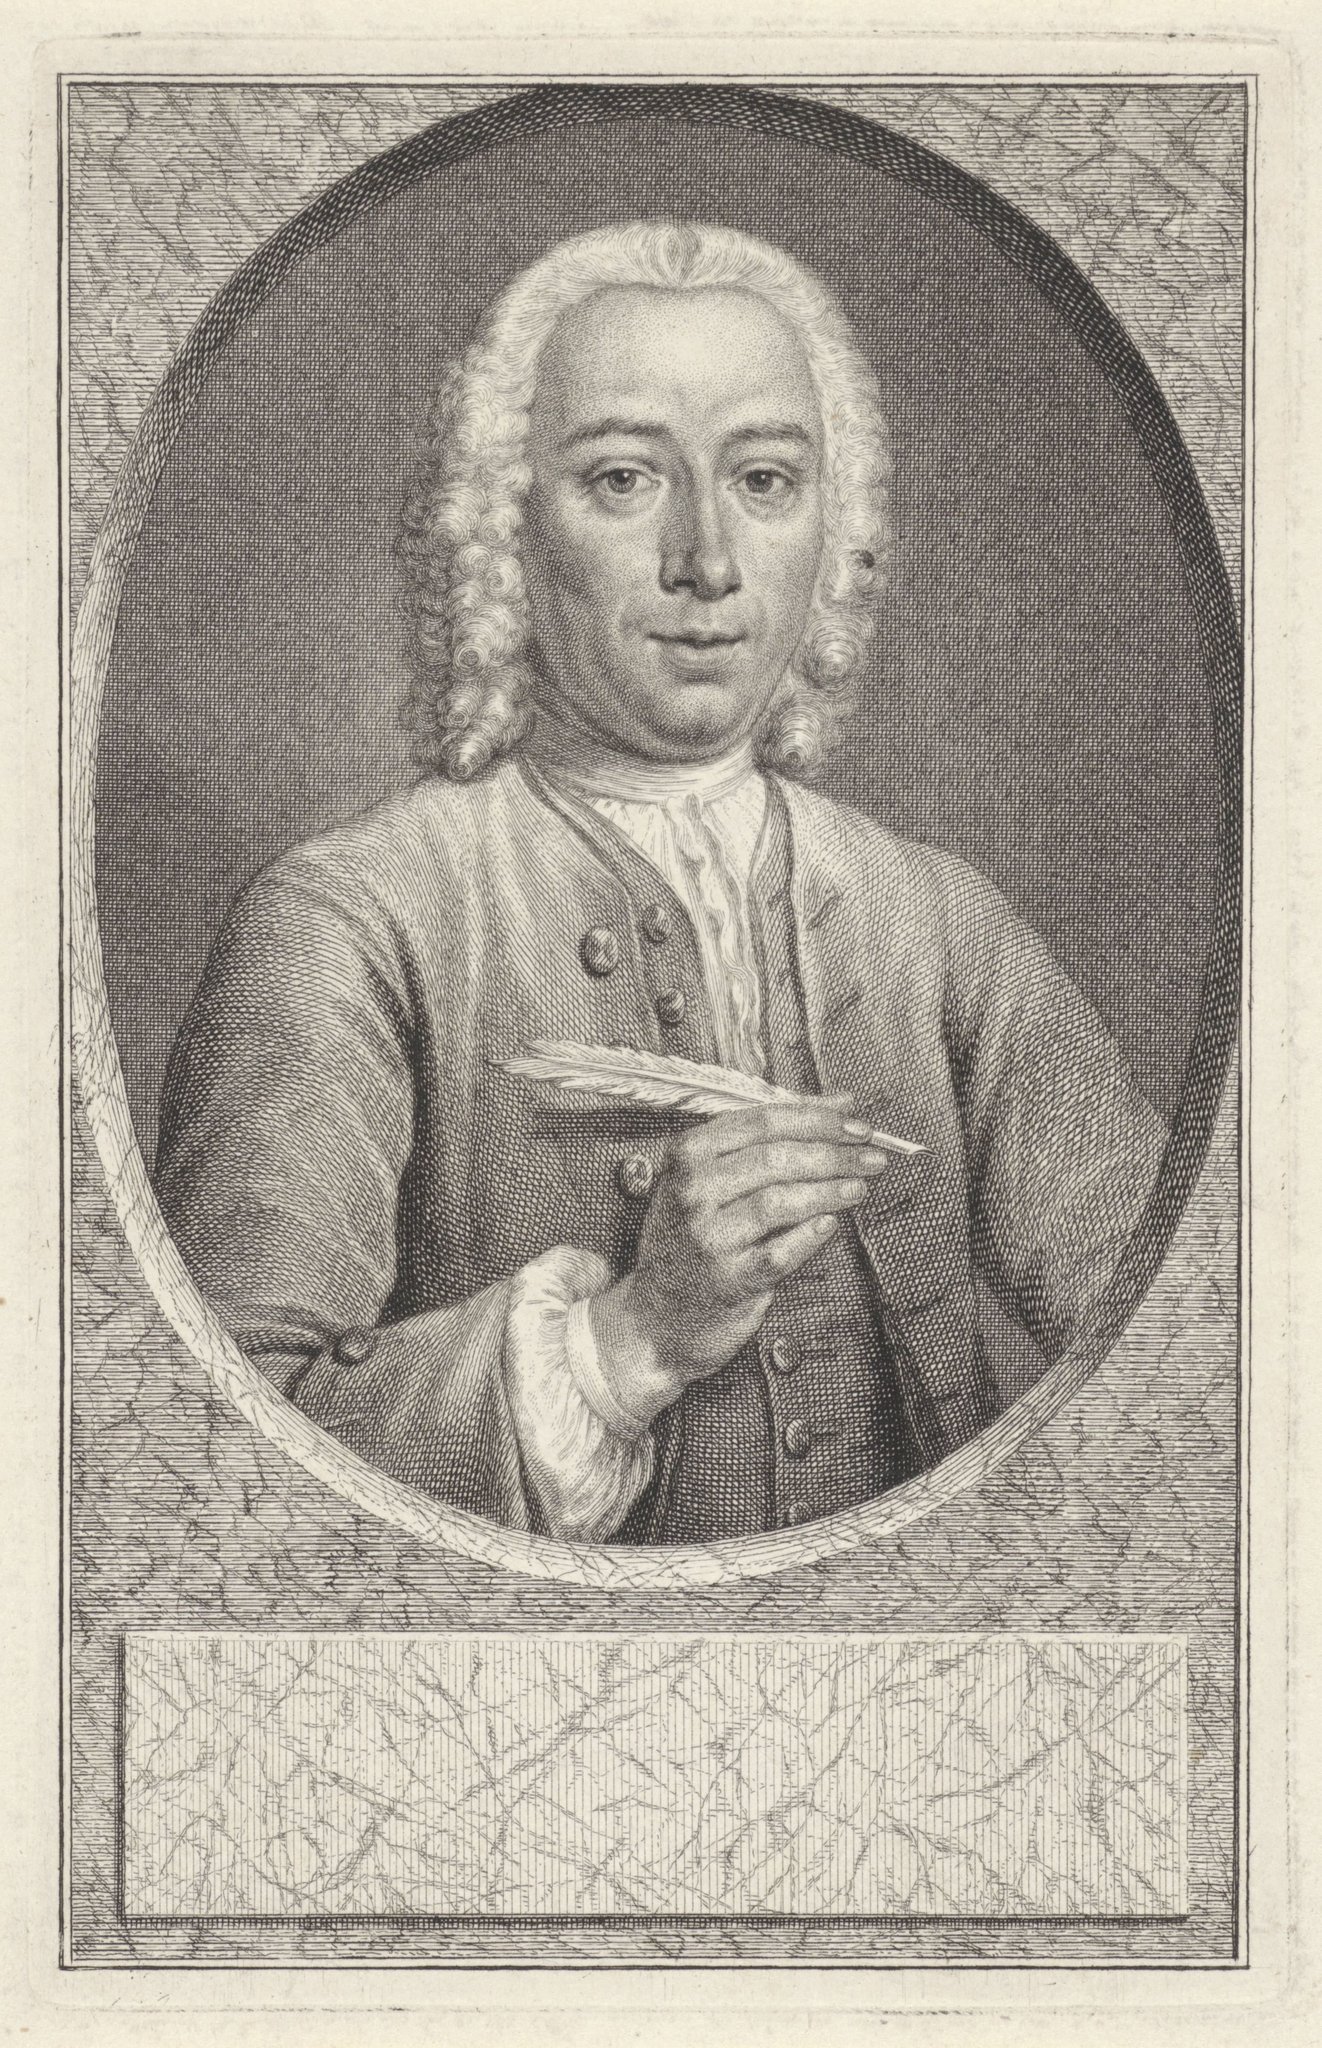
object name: print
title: Portret van Govert Klinkhamer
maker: pieter tanjé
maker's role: draughtsman, print maker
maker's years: 1706-1761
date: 1716-1761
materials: paper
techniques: engraving, etching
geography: amsterdam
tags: govert klinkhamer, writing tools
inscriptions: collector's mark: Lugt 240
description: Portret van Govert Klinkhamer, dichter van Bijbelse gedichten, met een schrijfveer in de hand.